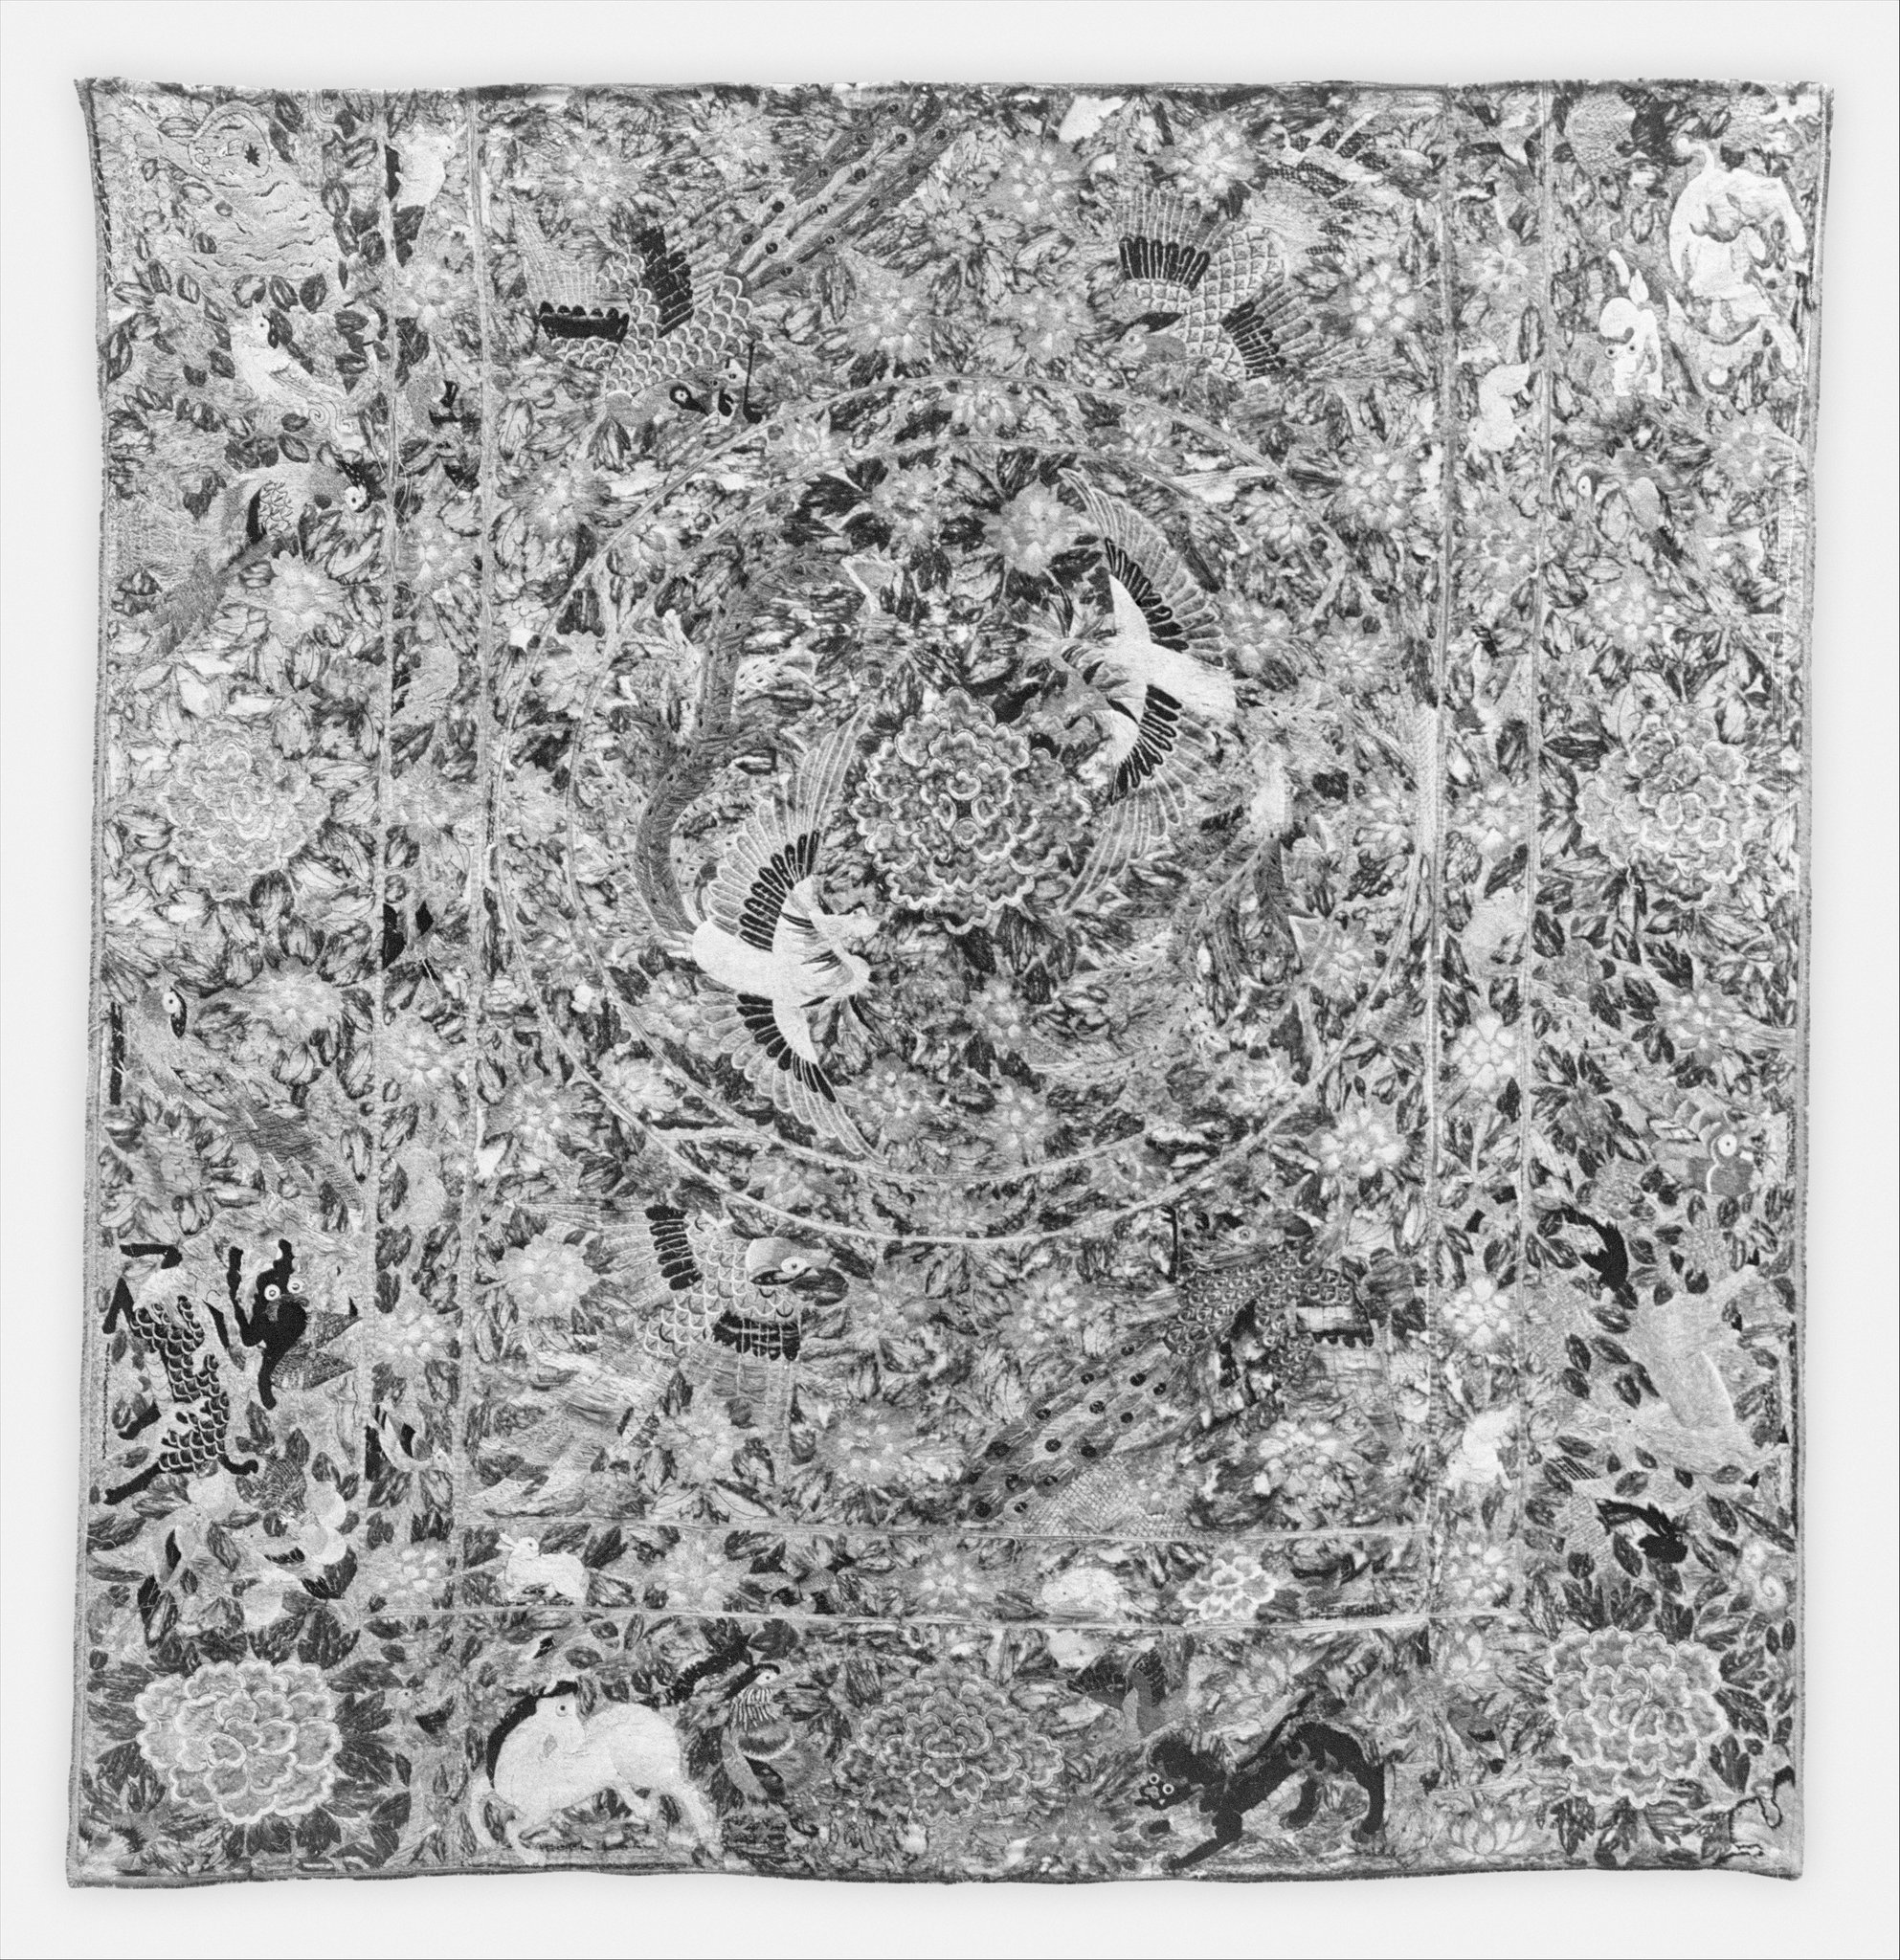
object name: panel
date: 1501-1600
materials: metal thread, silk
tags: birds,flowers,leaves